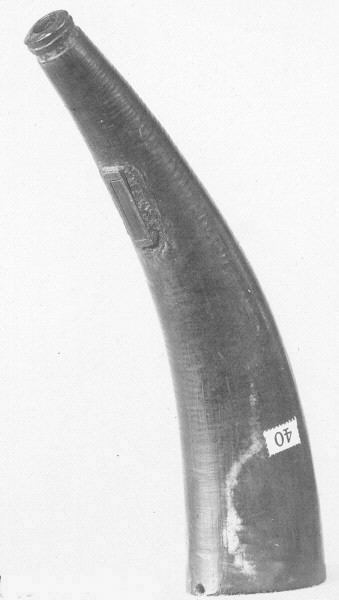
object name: gweh horn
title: Horn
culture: burmese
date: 1867-1900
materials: horn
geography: myanmar